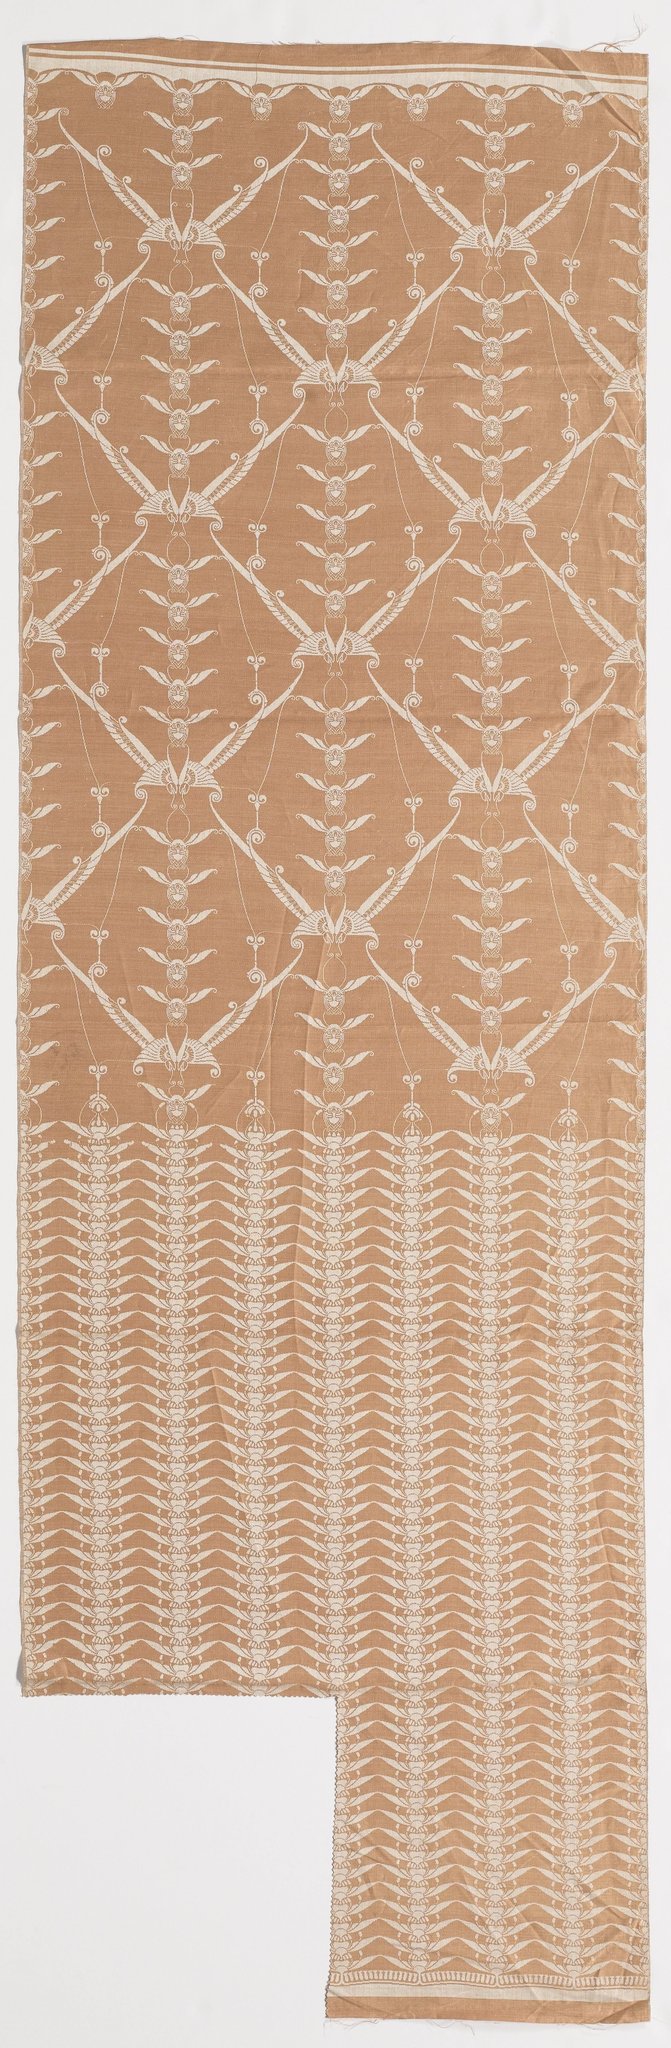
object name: upholstered wall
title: Wandbespanning met dessin "Wilde Vlucht"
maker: chris lebeau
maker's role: draughtsman, print maker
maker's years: 1878-1945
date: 1911-1915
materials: linen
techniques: damask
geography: eindhoven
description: Wall covering 'Wild hunt'. Linen damask. Eindhoven, NV Linnenfabrieken E.J. van Dissel en Zonen, c. 1911 - 1915, designed by Chris Lebeau.